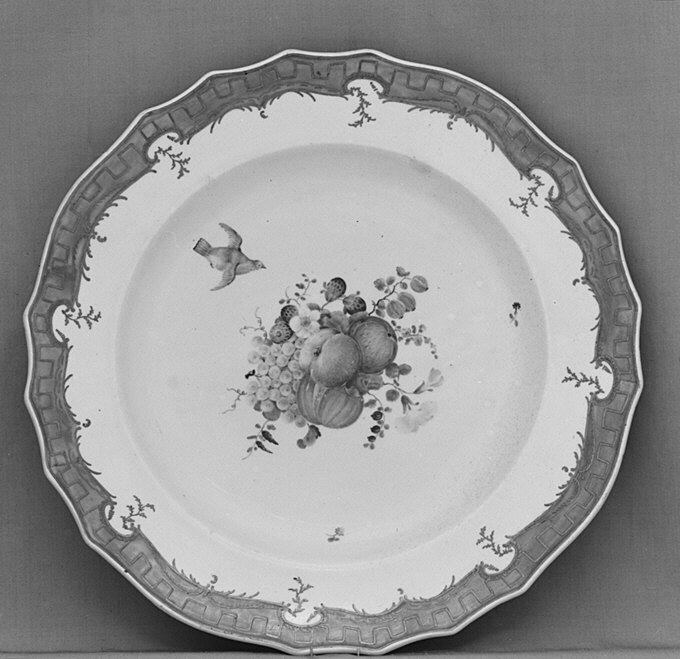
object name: plate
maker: the hague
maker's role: factory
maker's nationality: dutch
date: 1780-1785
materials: hard paste porcelain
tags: birds,fruit,flowers